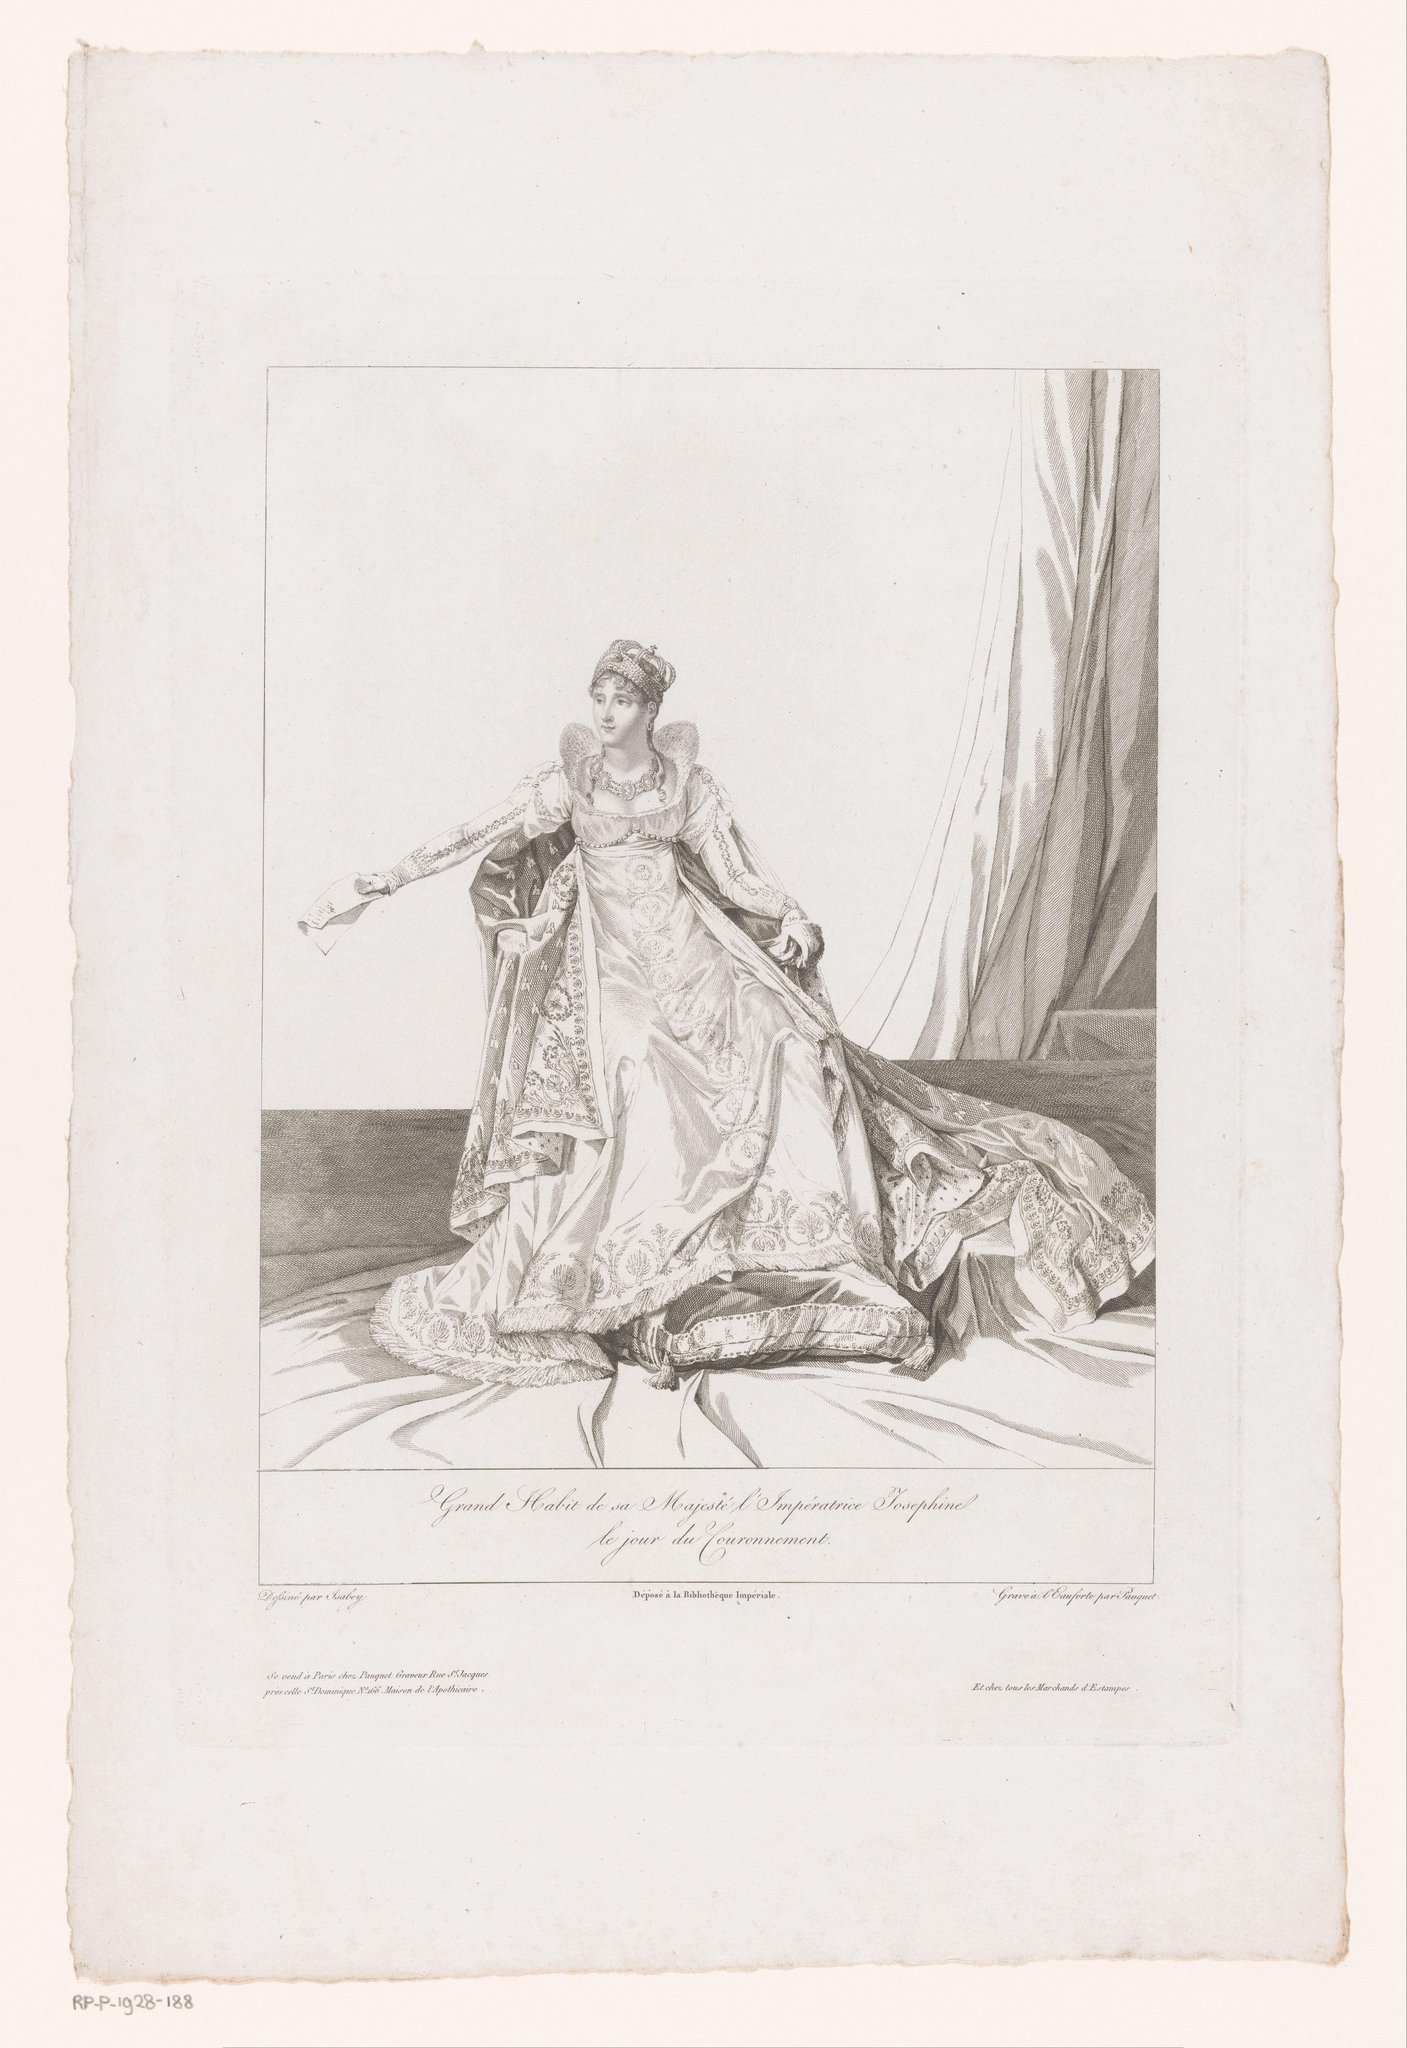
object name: print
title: Portret van Josephine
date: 1804-1824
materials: paper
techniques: etching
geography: paris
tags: joséphine de beauharnais, historical persons, emperor - bb - female ruler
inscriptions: : ‘Déposé à la Bibliothèque Impériale’, collector's mark: Lugt 2228